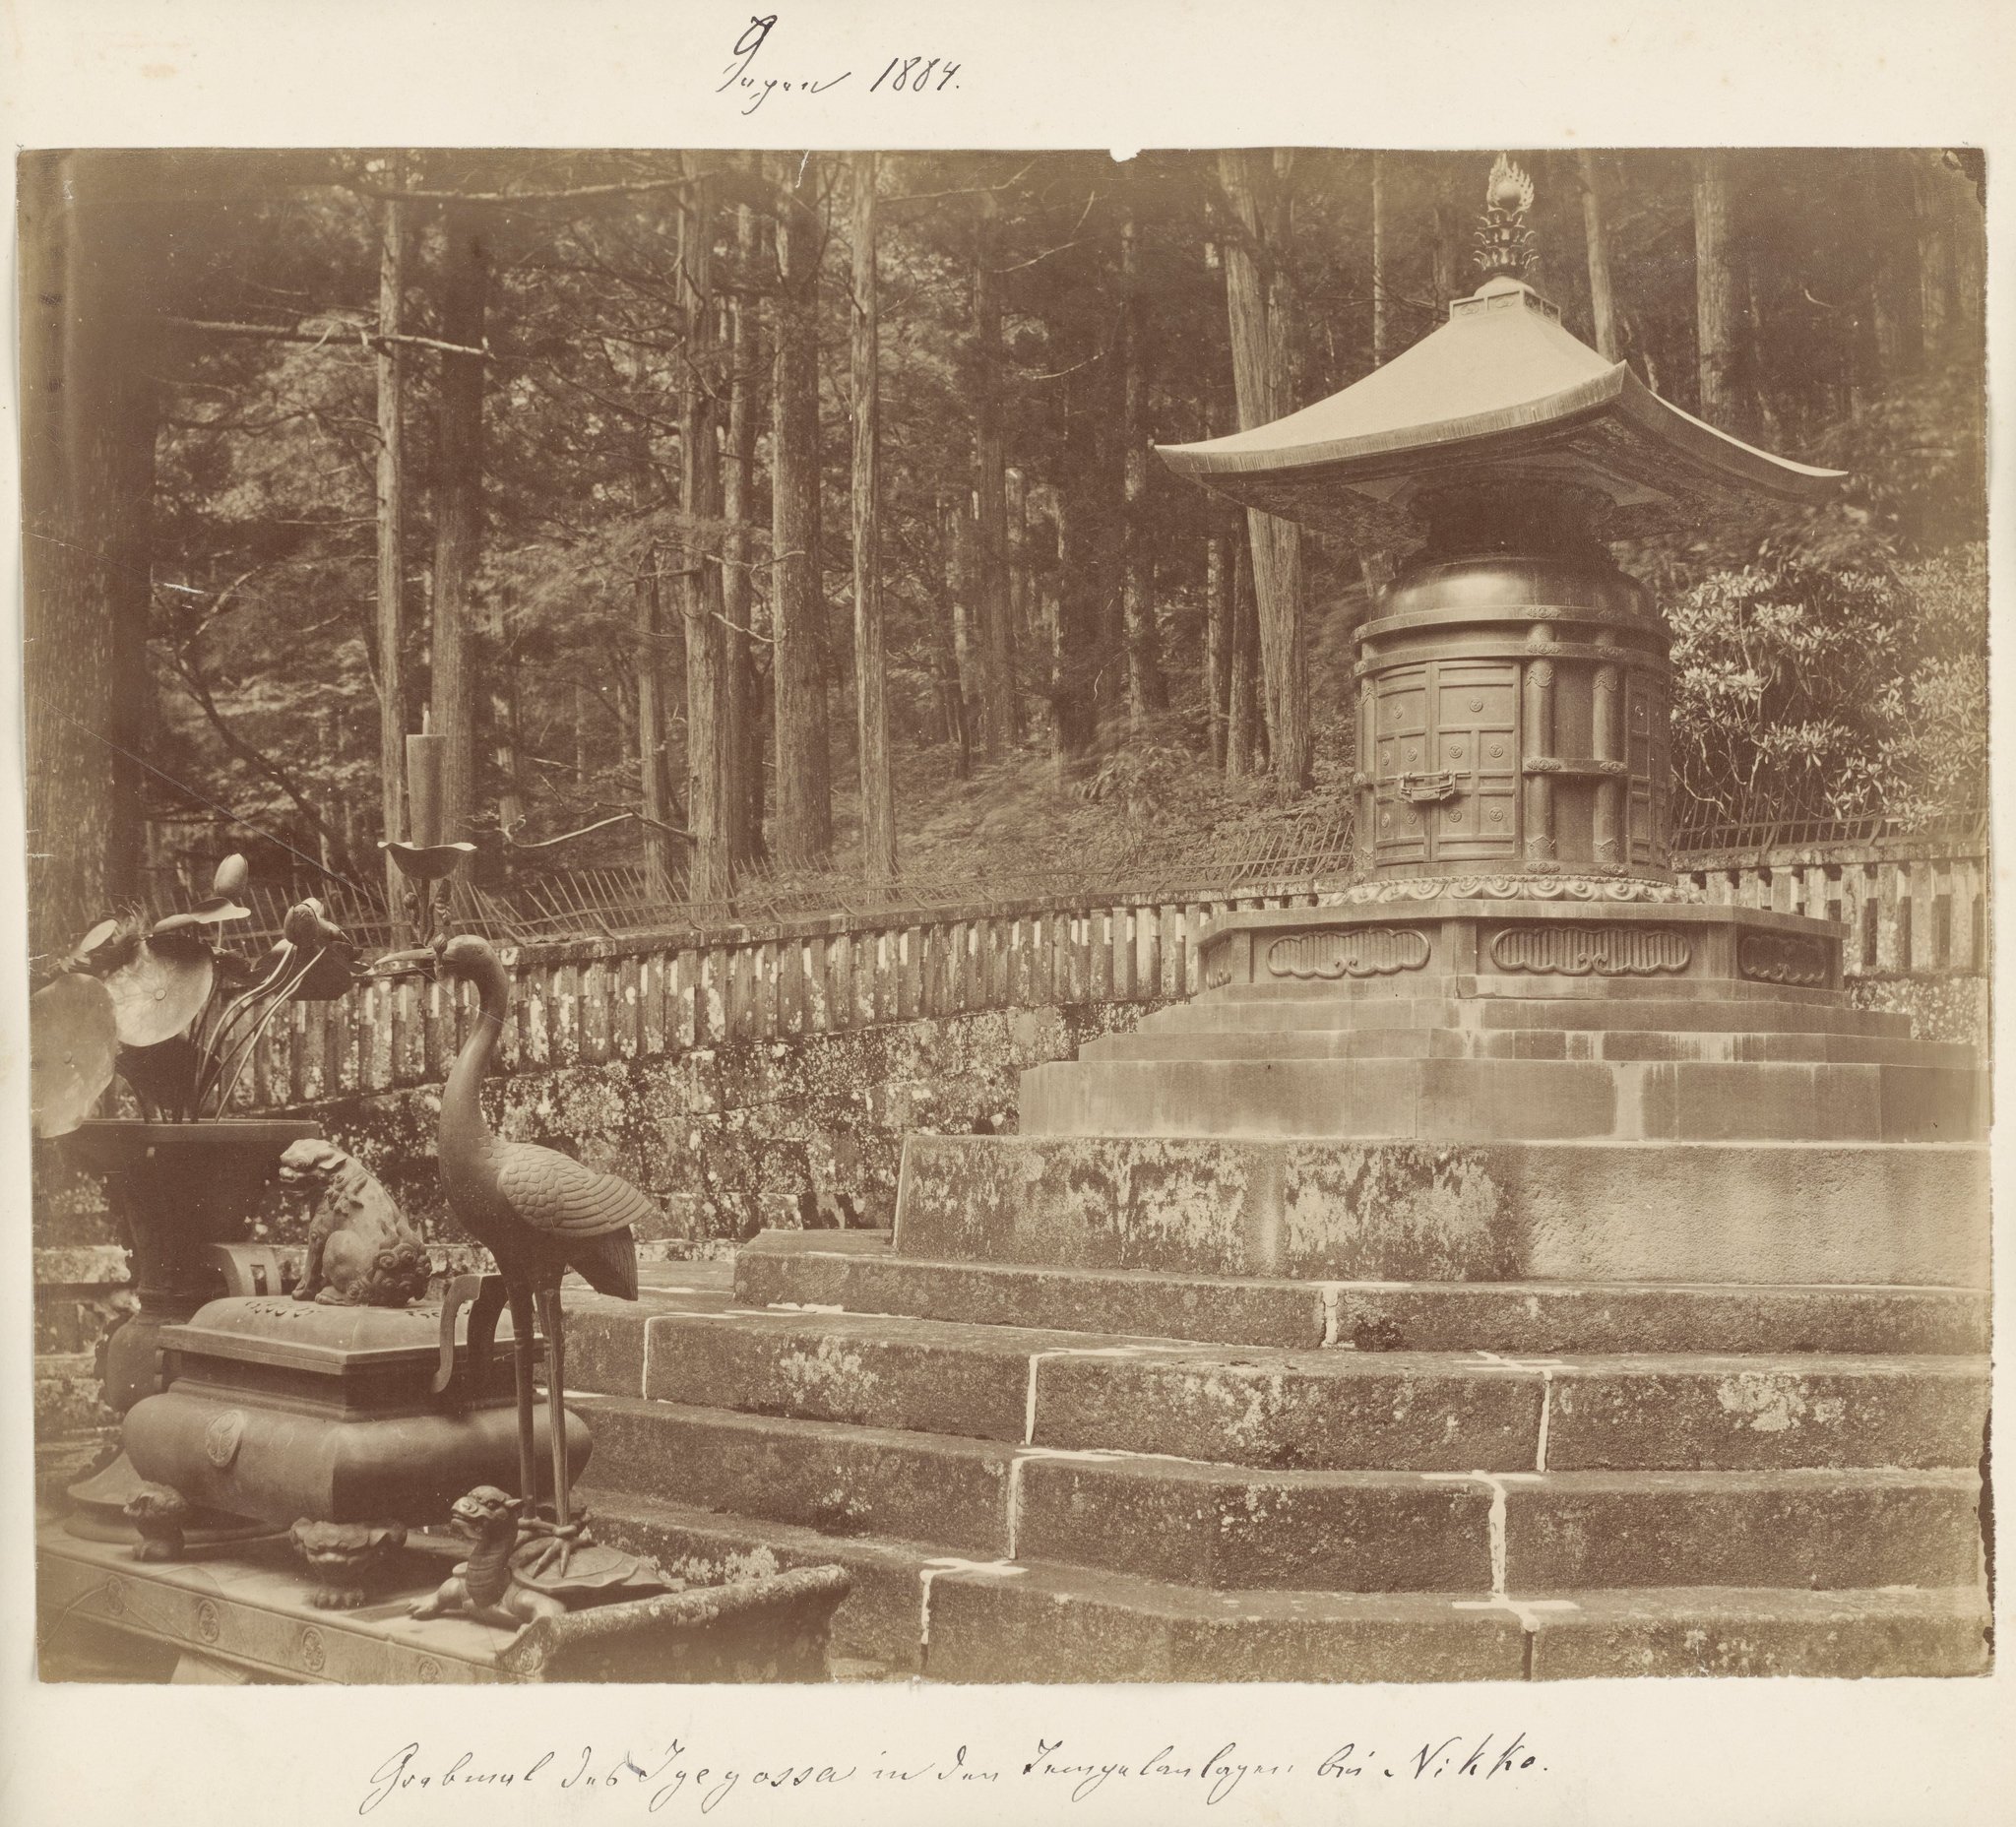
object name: photograph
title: Japan 1884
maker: Anonymous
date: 1884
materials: cardboard, paper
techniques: albumen print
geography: nikkō tōshō-gū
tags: japan, grave, tomb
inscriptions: inscription: ‘Grab von [...] bei Nikko’